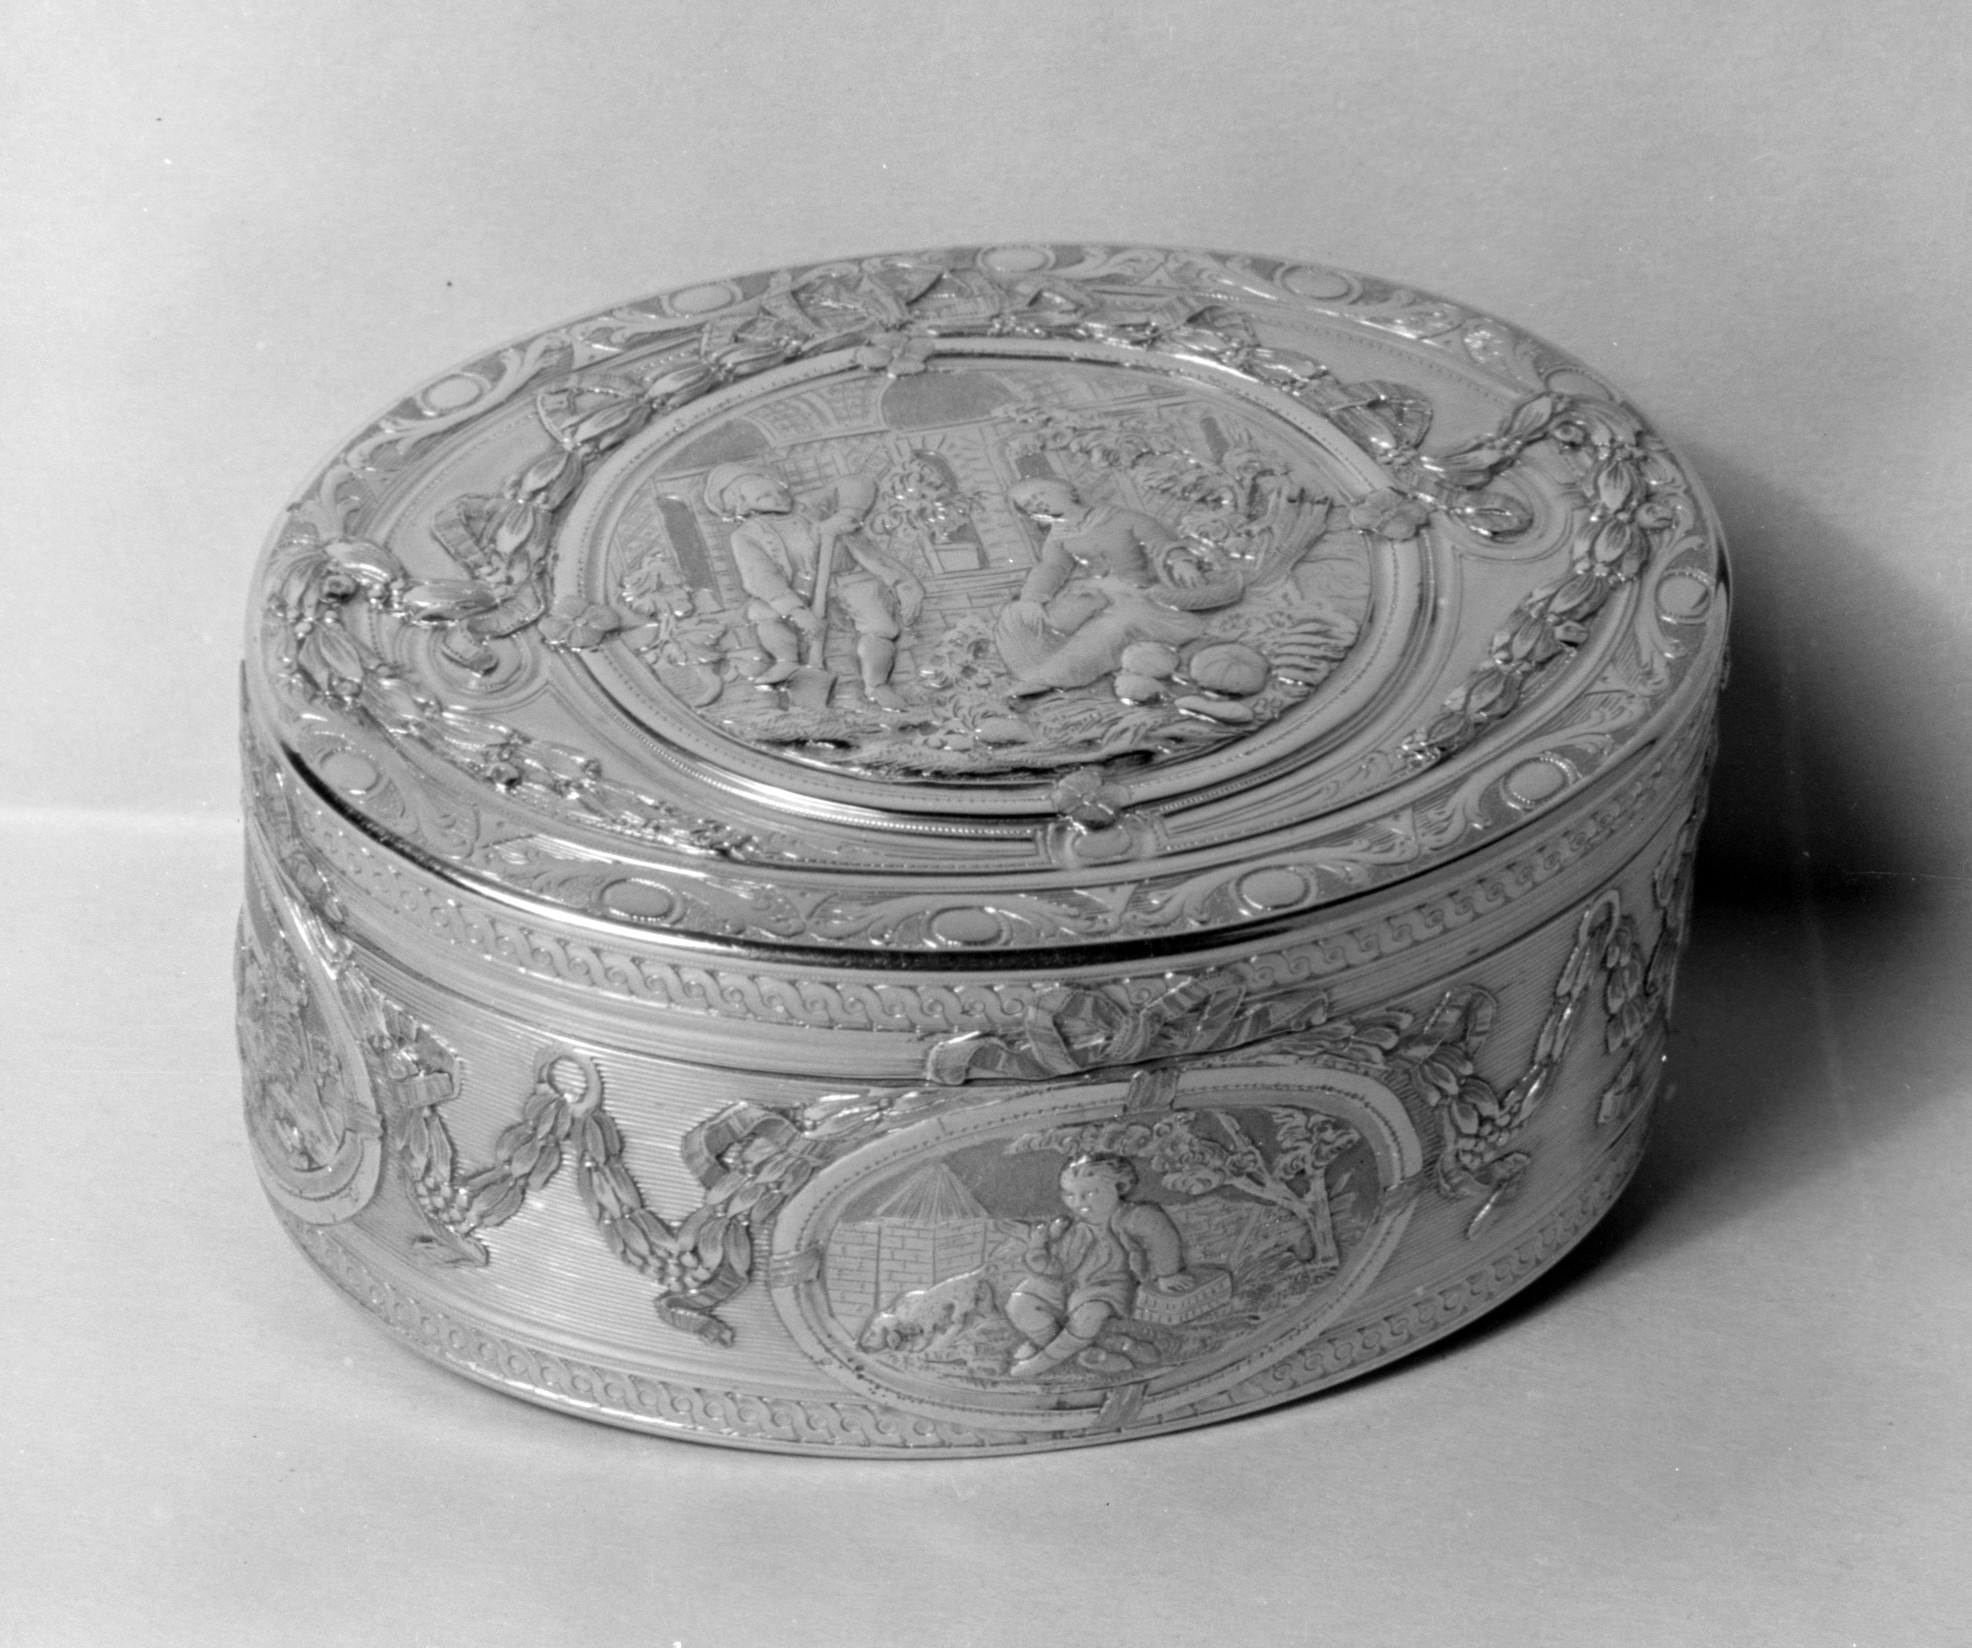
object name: snuffbox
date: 1762-1763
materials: gold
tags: human figures